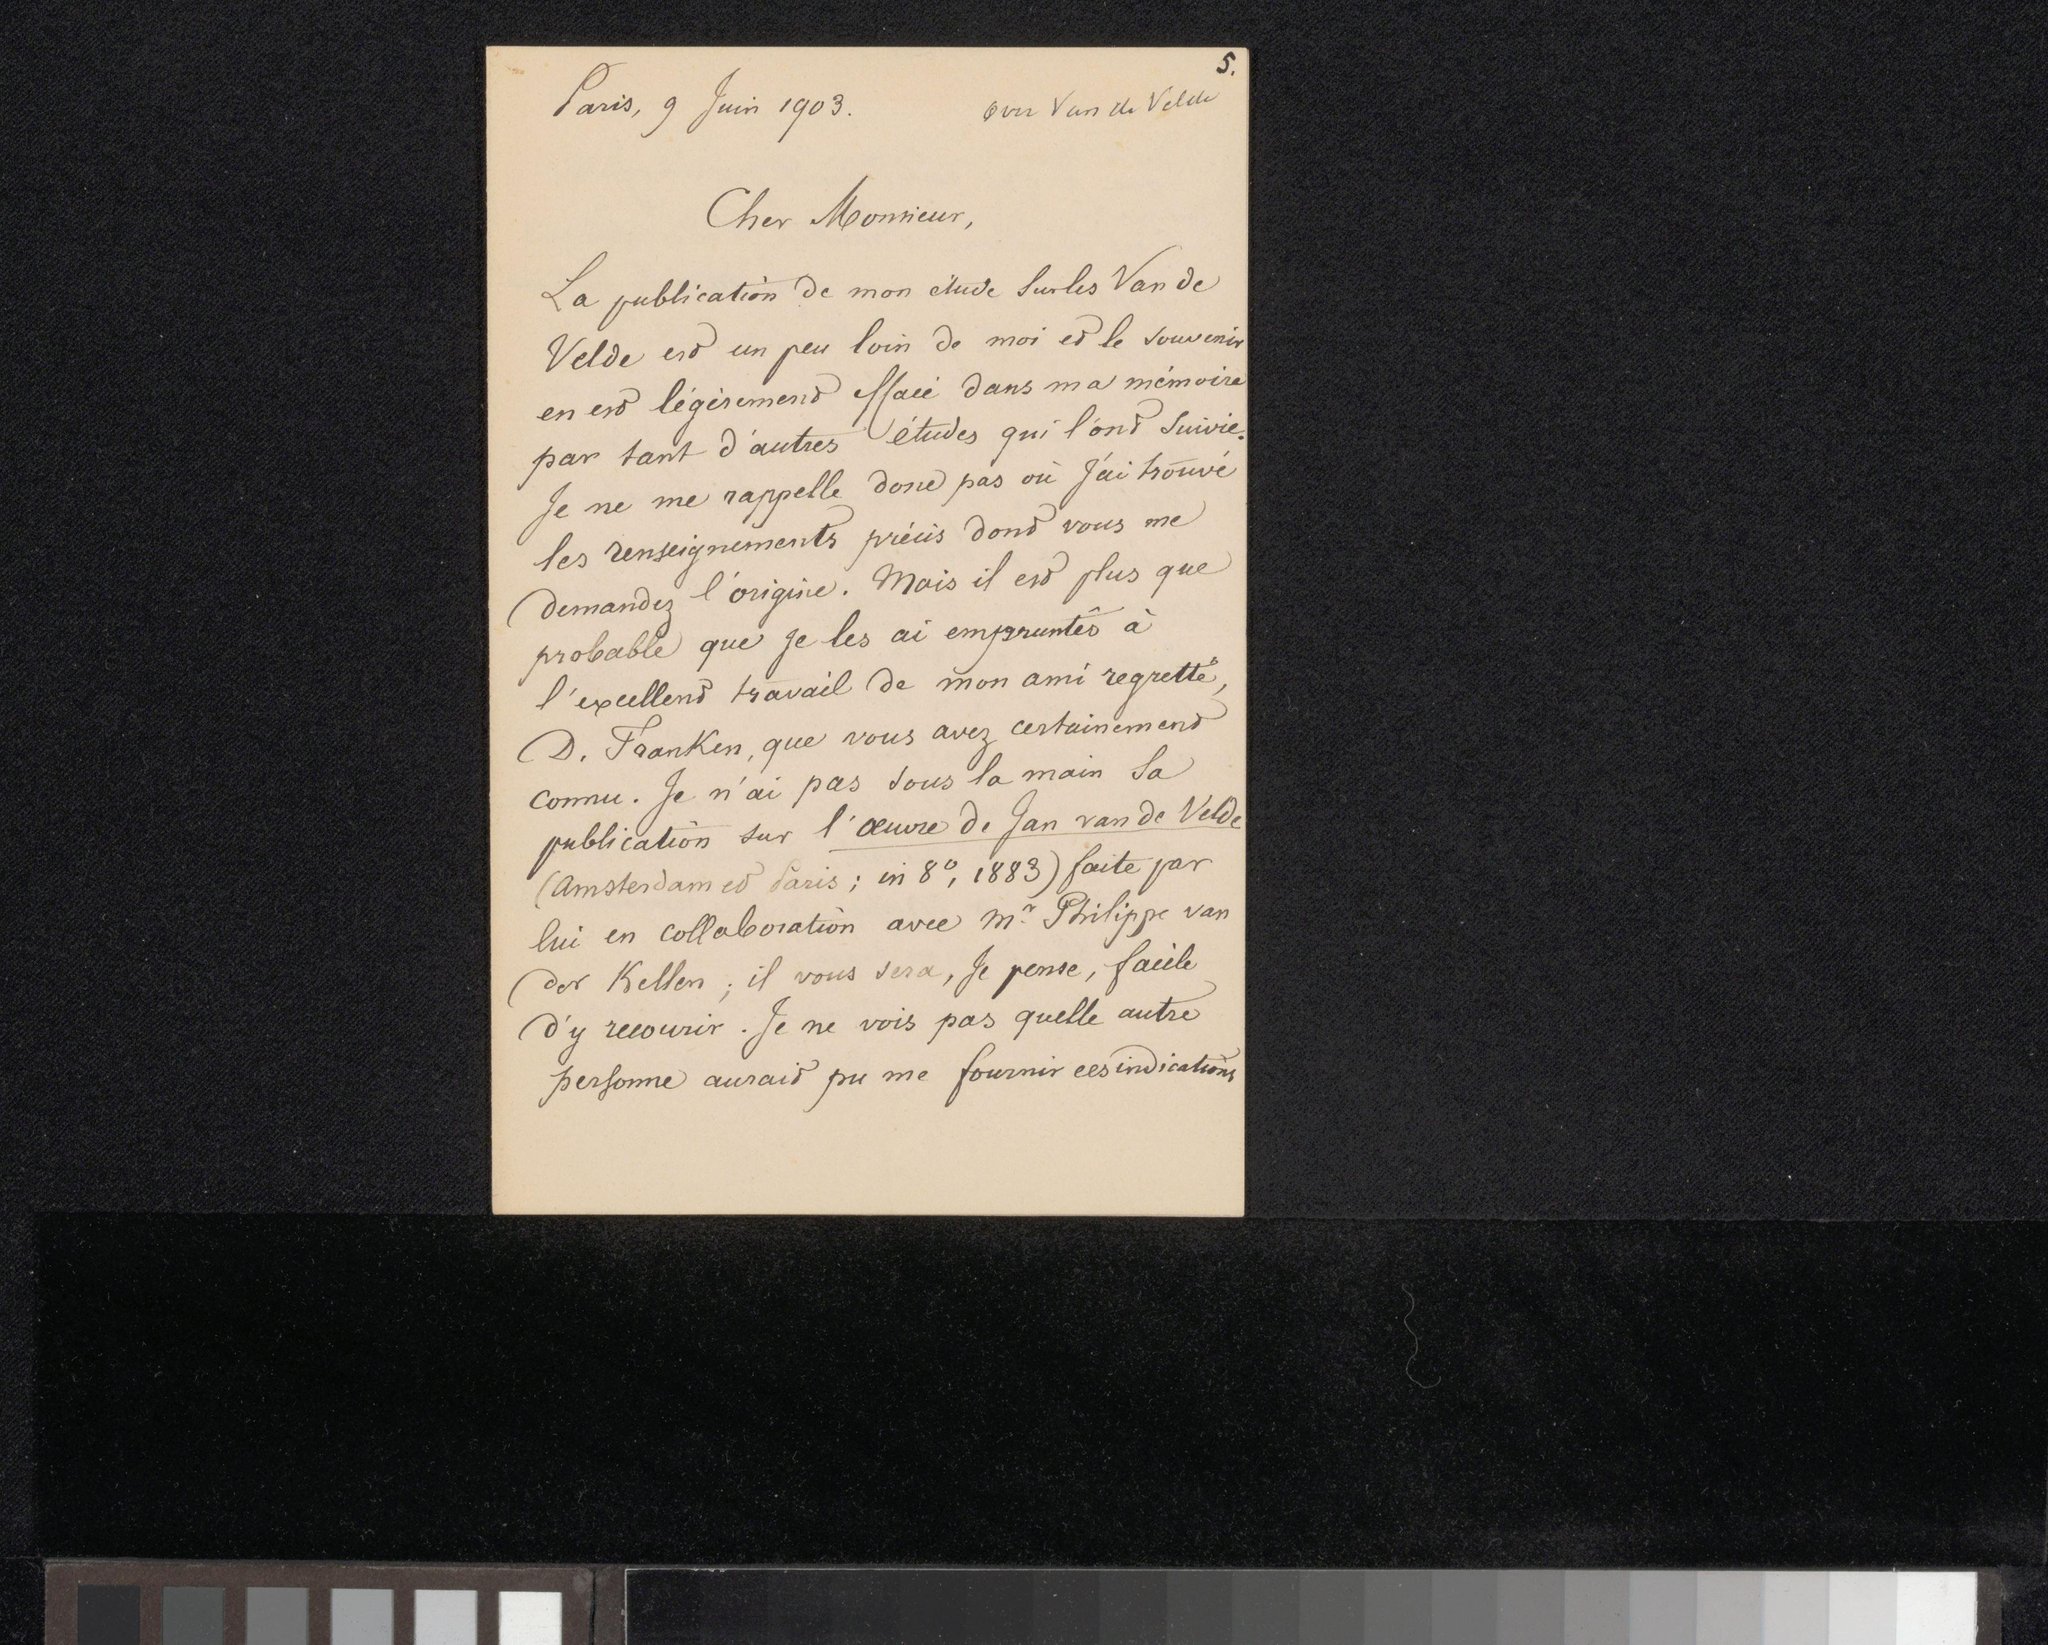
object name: letter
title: Brief aan Pieter Haverkorn van Rijsewijk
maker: françois émile michel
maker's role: painter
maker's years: 1828-1909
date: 1903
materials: ink, paper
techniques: pen, writing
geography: paris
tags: haarlem, painter, jan van de velde (i), pieter haverkorn van rijsewijk, daniël franken dzn., delft, enkhuizen, print maker, draughtsman, jan van de velde (ii), drawing, historical persons (portraits and scenes from the life)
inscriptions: watermark, collector's mark: ‘RPK’